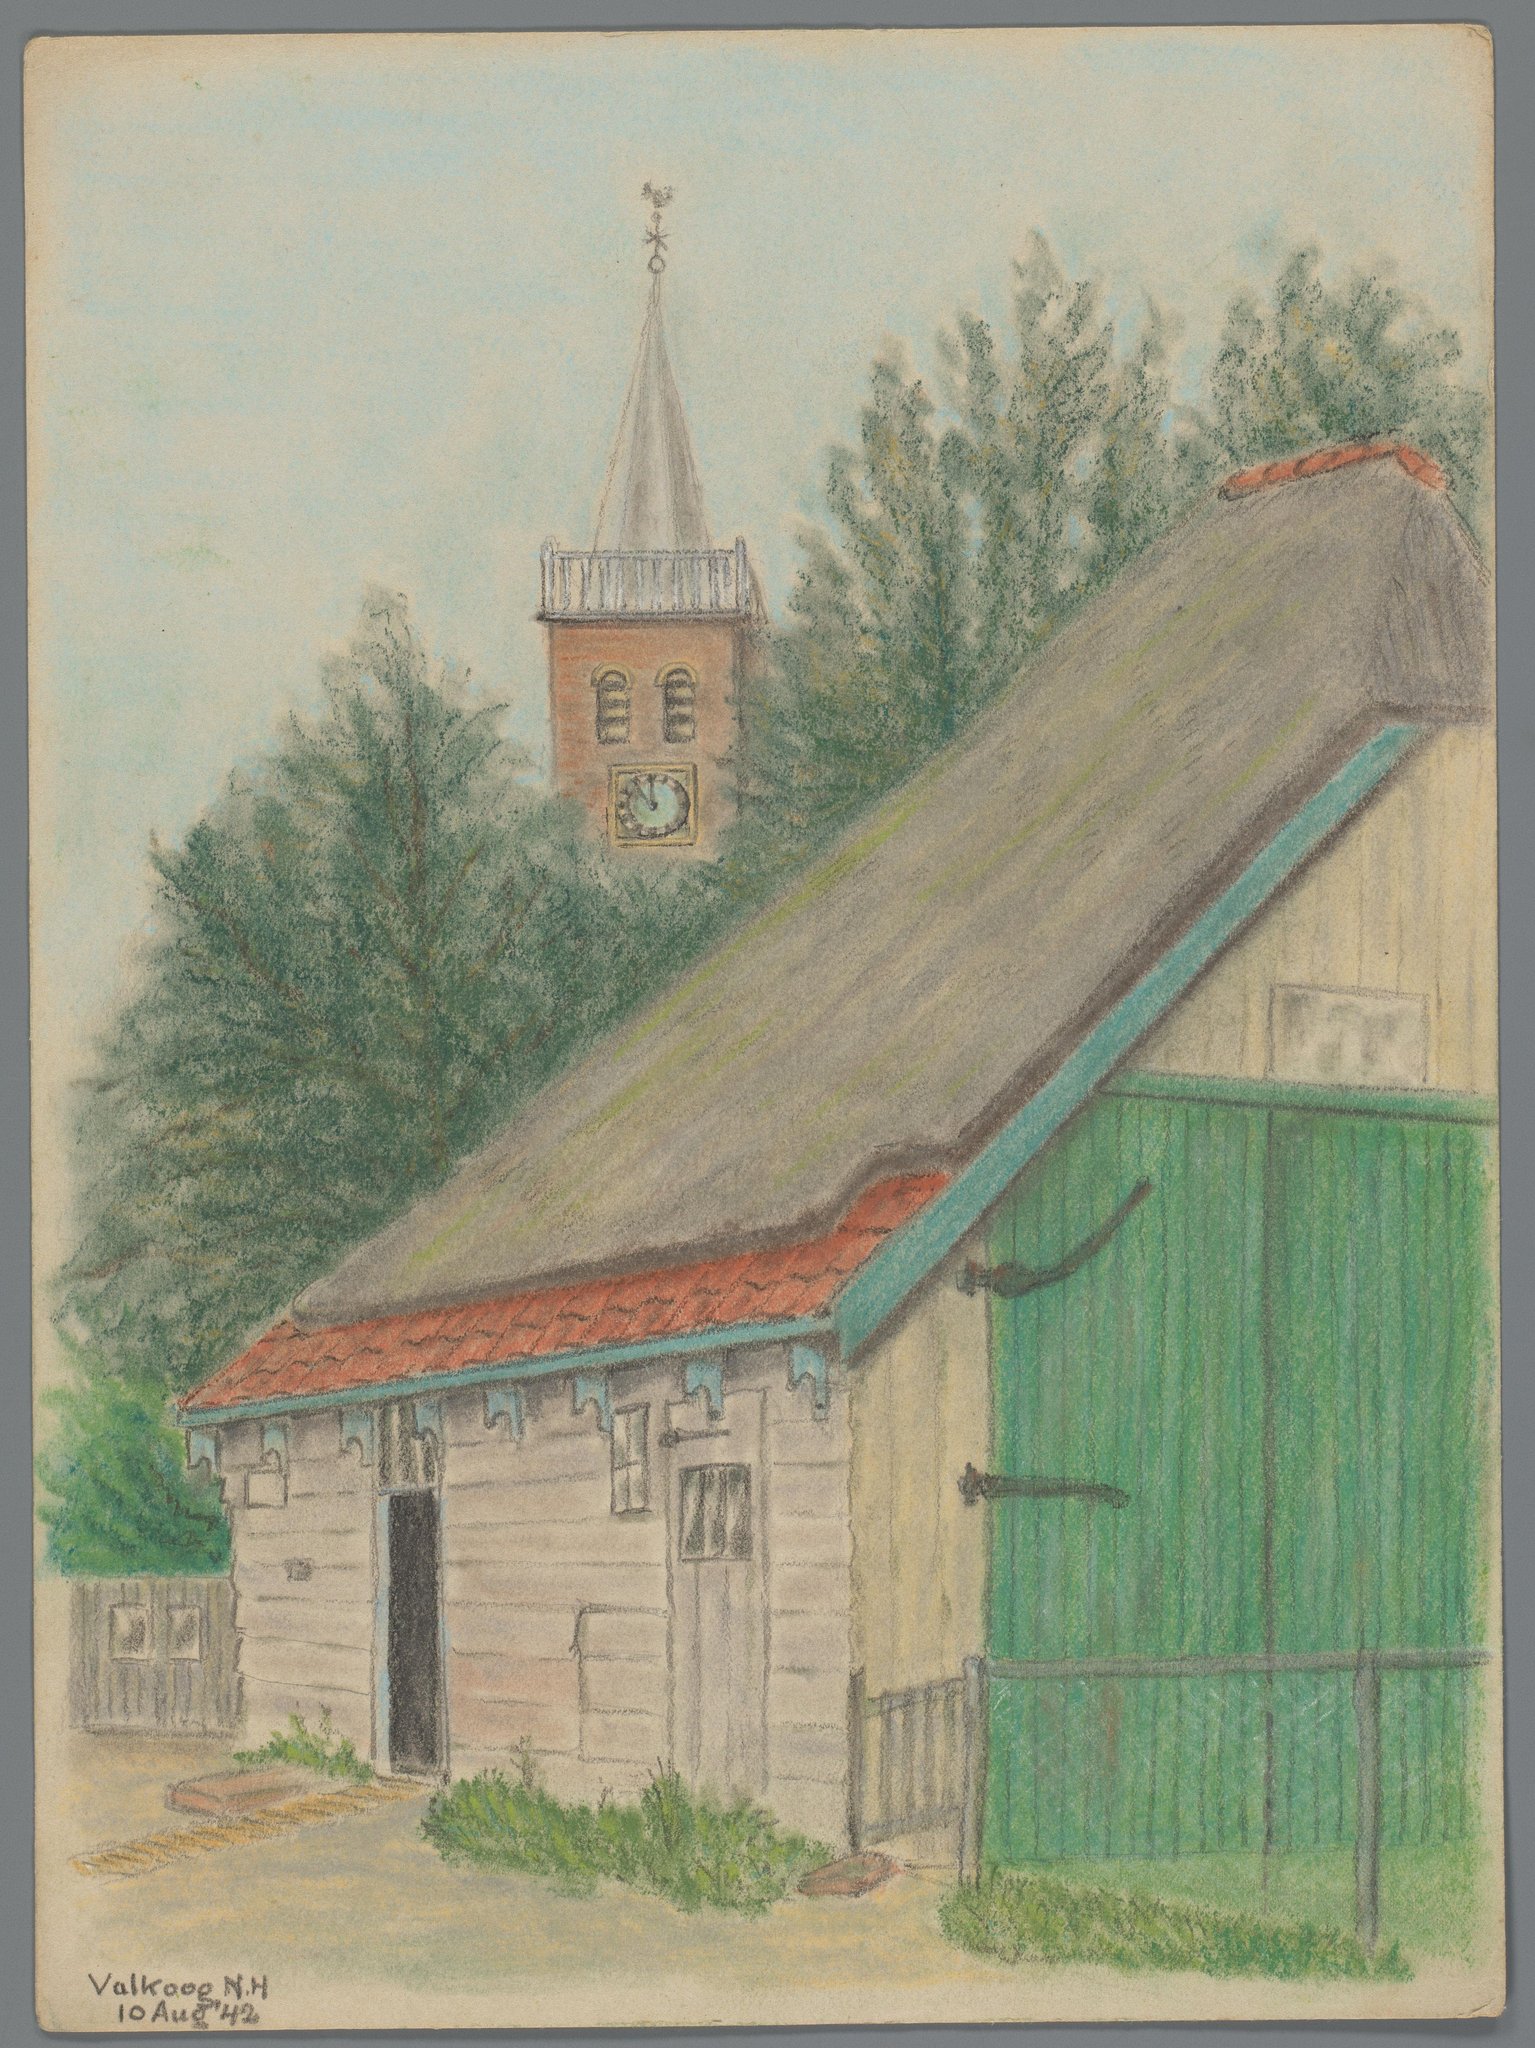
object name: drawing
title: Gezicht op een schuur en de kerktoren van Valkkoog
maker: jacob olie jr.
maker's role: fotograaf, scheikundige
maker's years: 1879-1955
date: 1942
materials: chalk, pastel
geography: valkkoog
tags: city-view in general; 'veduta', parts of church exterior and annexes: tower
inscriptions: annotation: ‘Valkoog N.H./ 10 Aug '42’